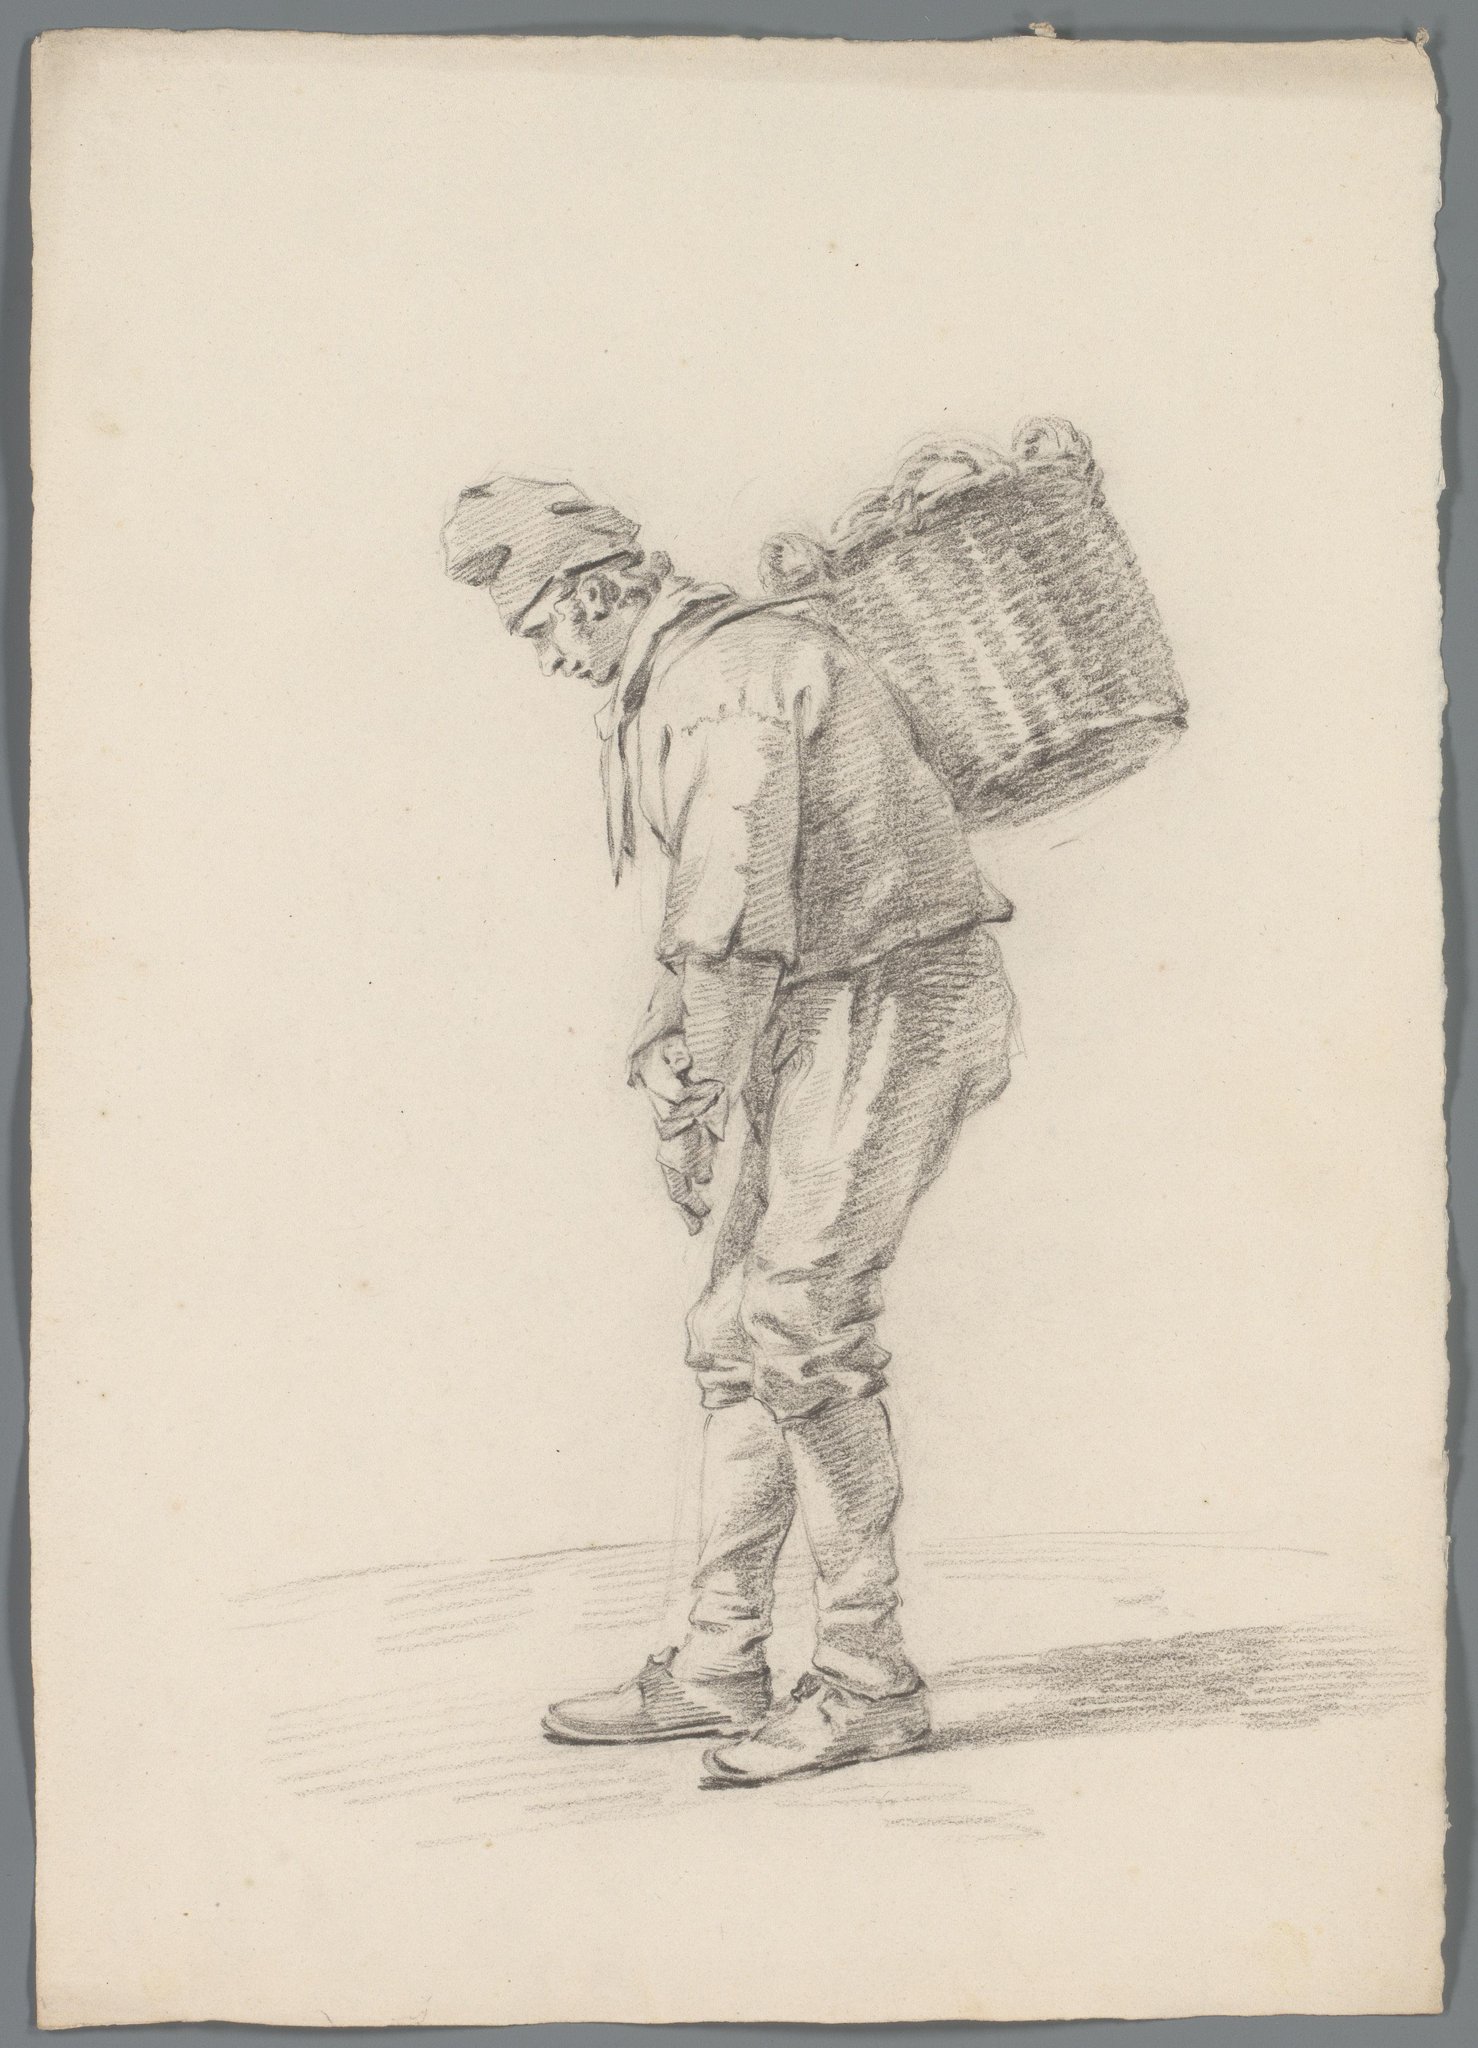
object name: drawing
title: Man met een mand op zijn rug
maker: Anonymous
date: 1820-1830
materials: chalk, paper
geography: the hague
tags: adult man, container made of plant material other than wood: basket, head-gear: hat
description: Tekeningen waarschijnlijk ontstaan bij het Haagse kunstgenootschap ‘Tot Nut der Tekenkunst’, waar twee keer per week tekenavonden werden georganiseerd met geklede modellen.